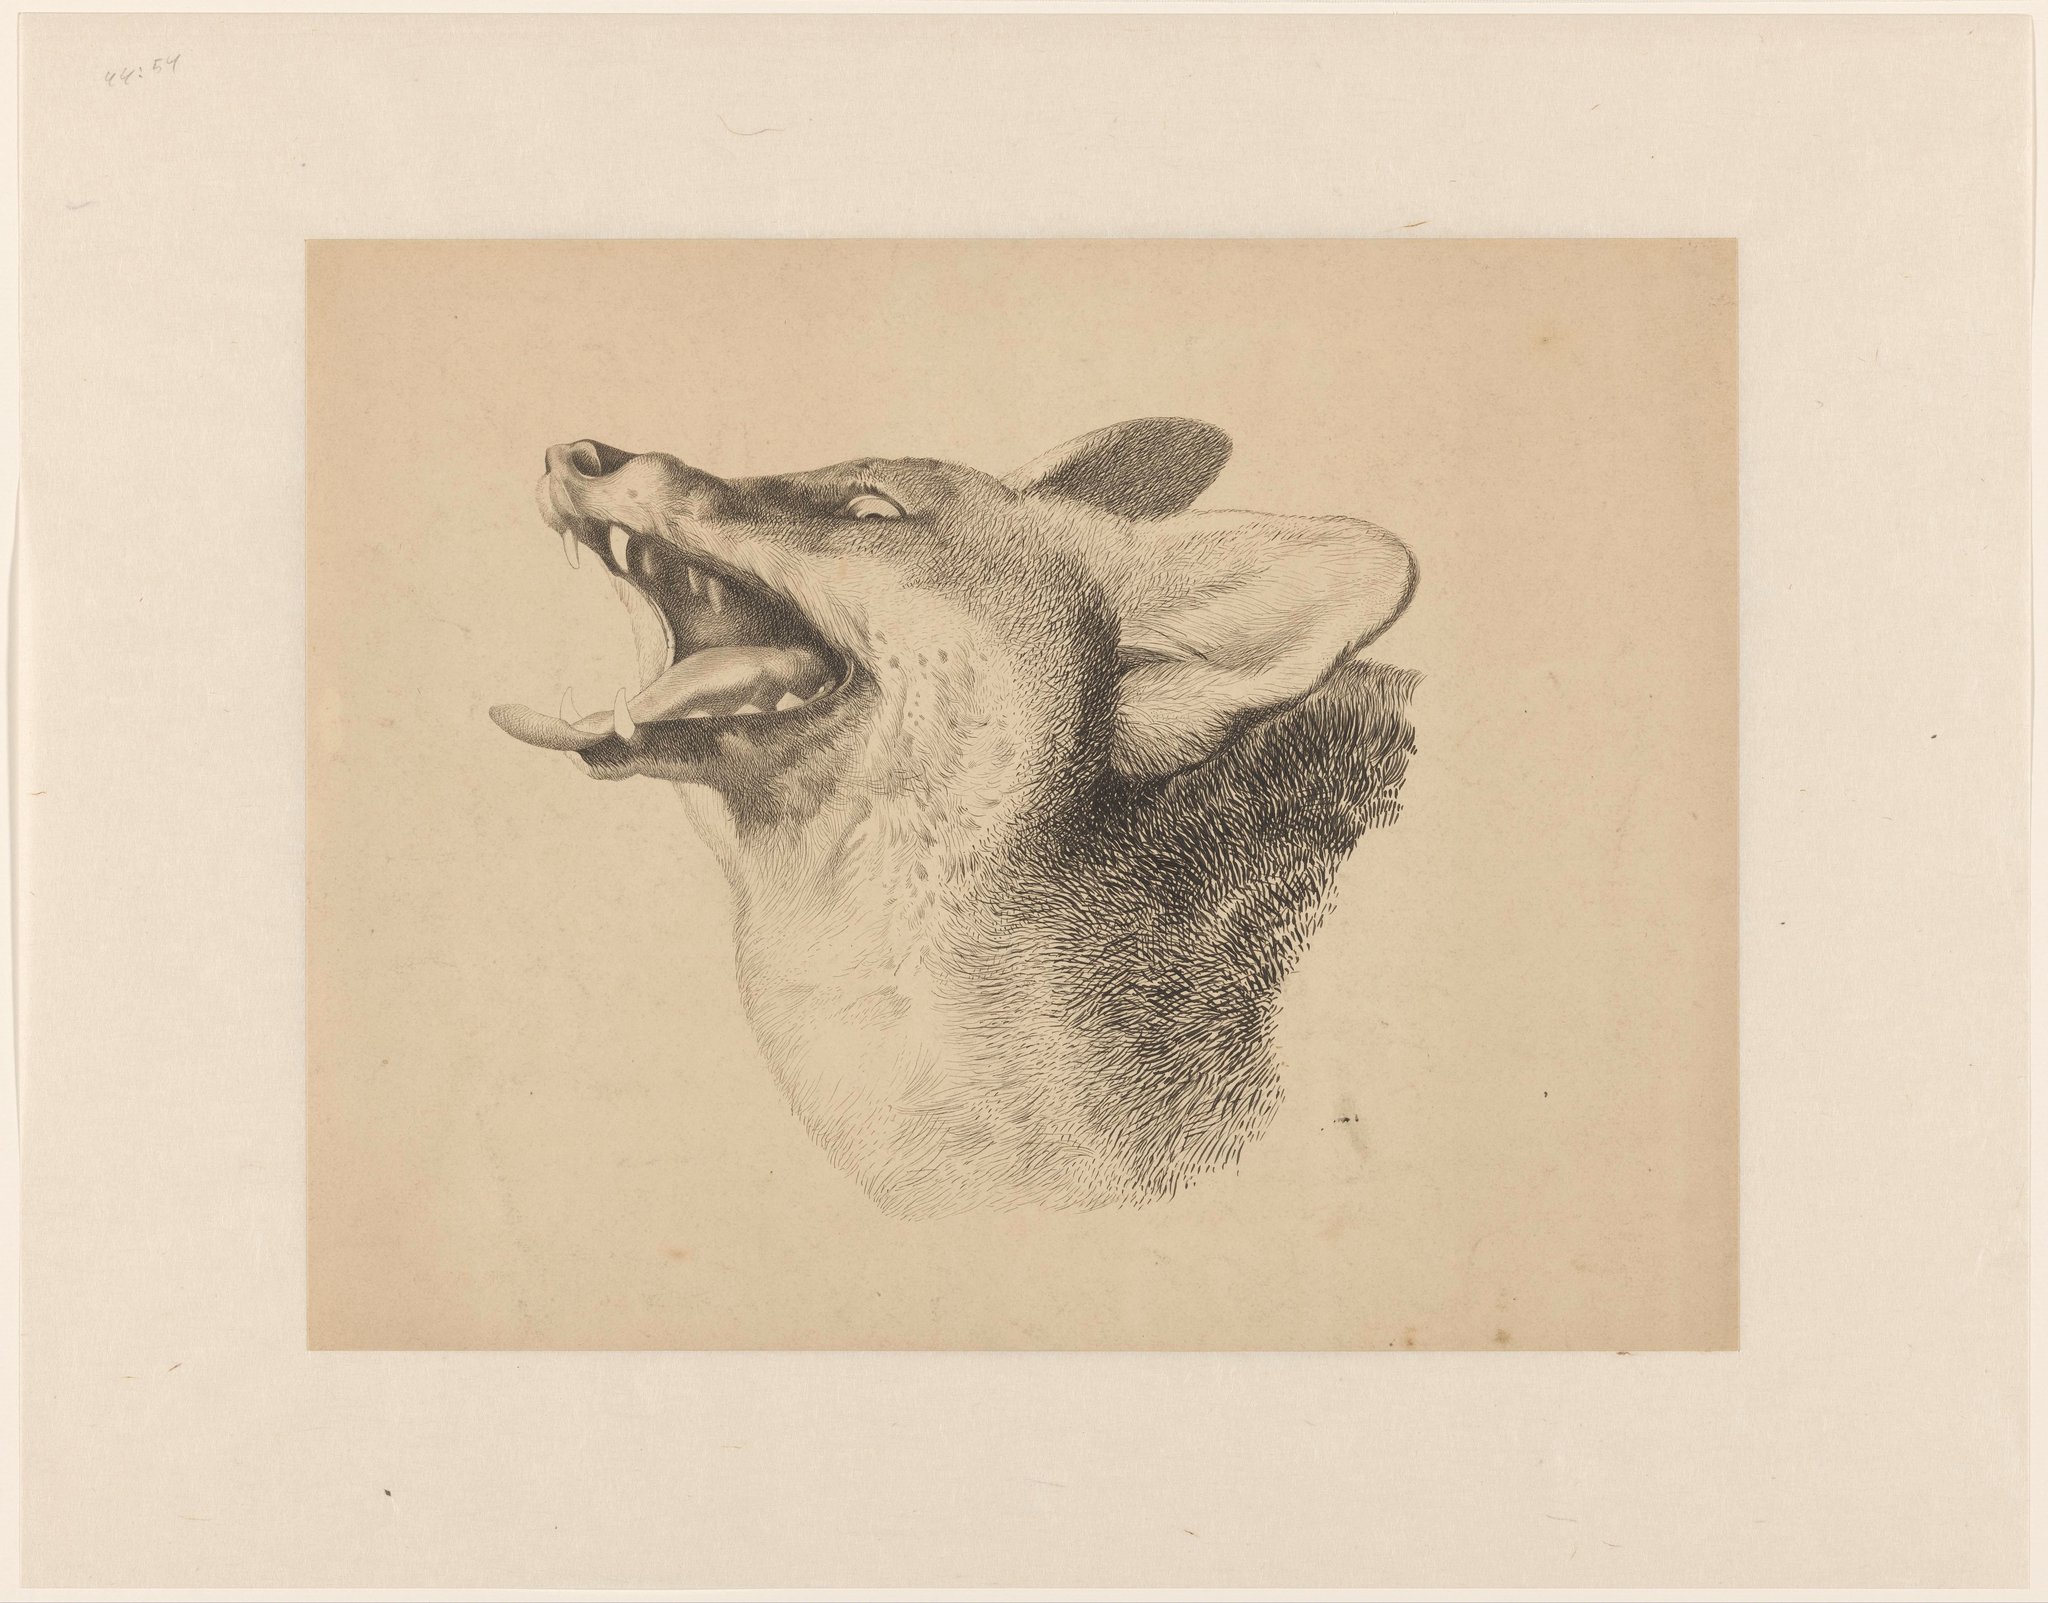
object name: drawing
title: Kop van een vos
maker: joseph mendes da costa (1806-1893)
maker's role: draughtsman, print maker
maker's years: 1806-1893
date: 1816-1893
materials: ink, paper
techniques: pen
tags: beasts of prey, predatory animals: fox